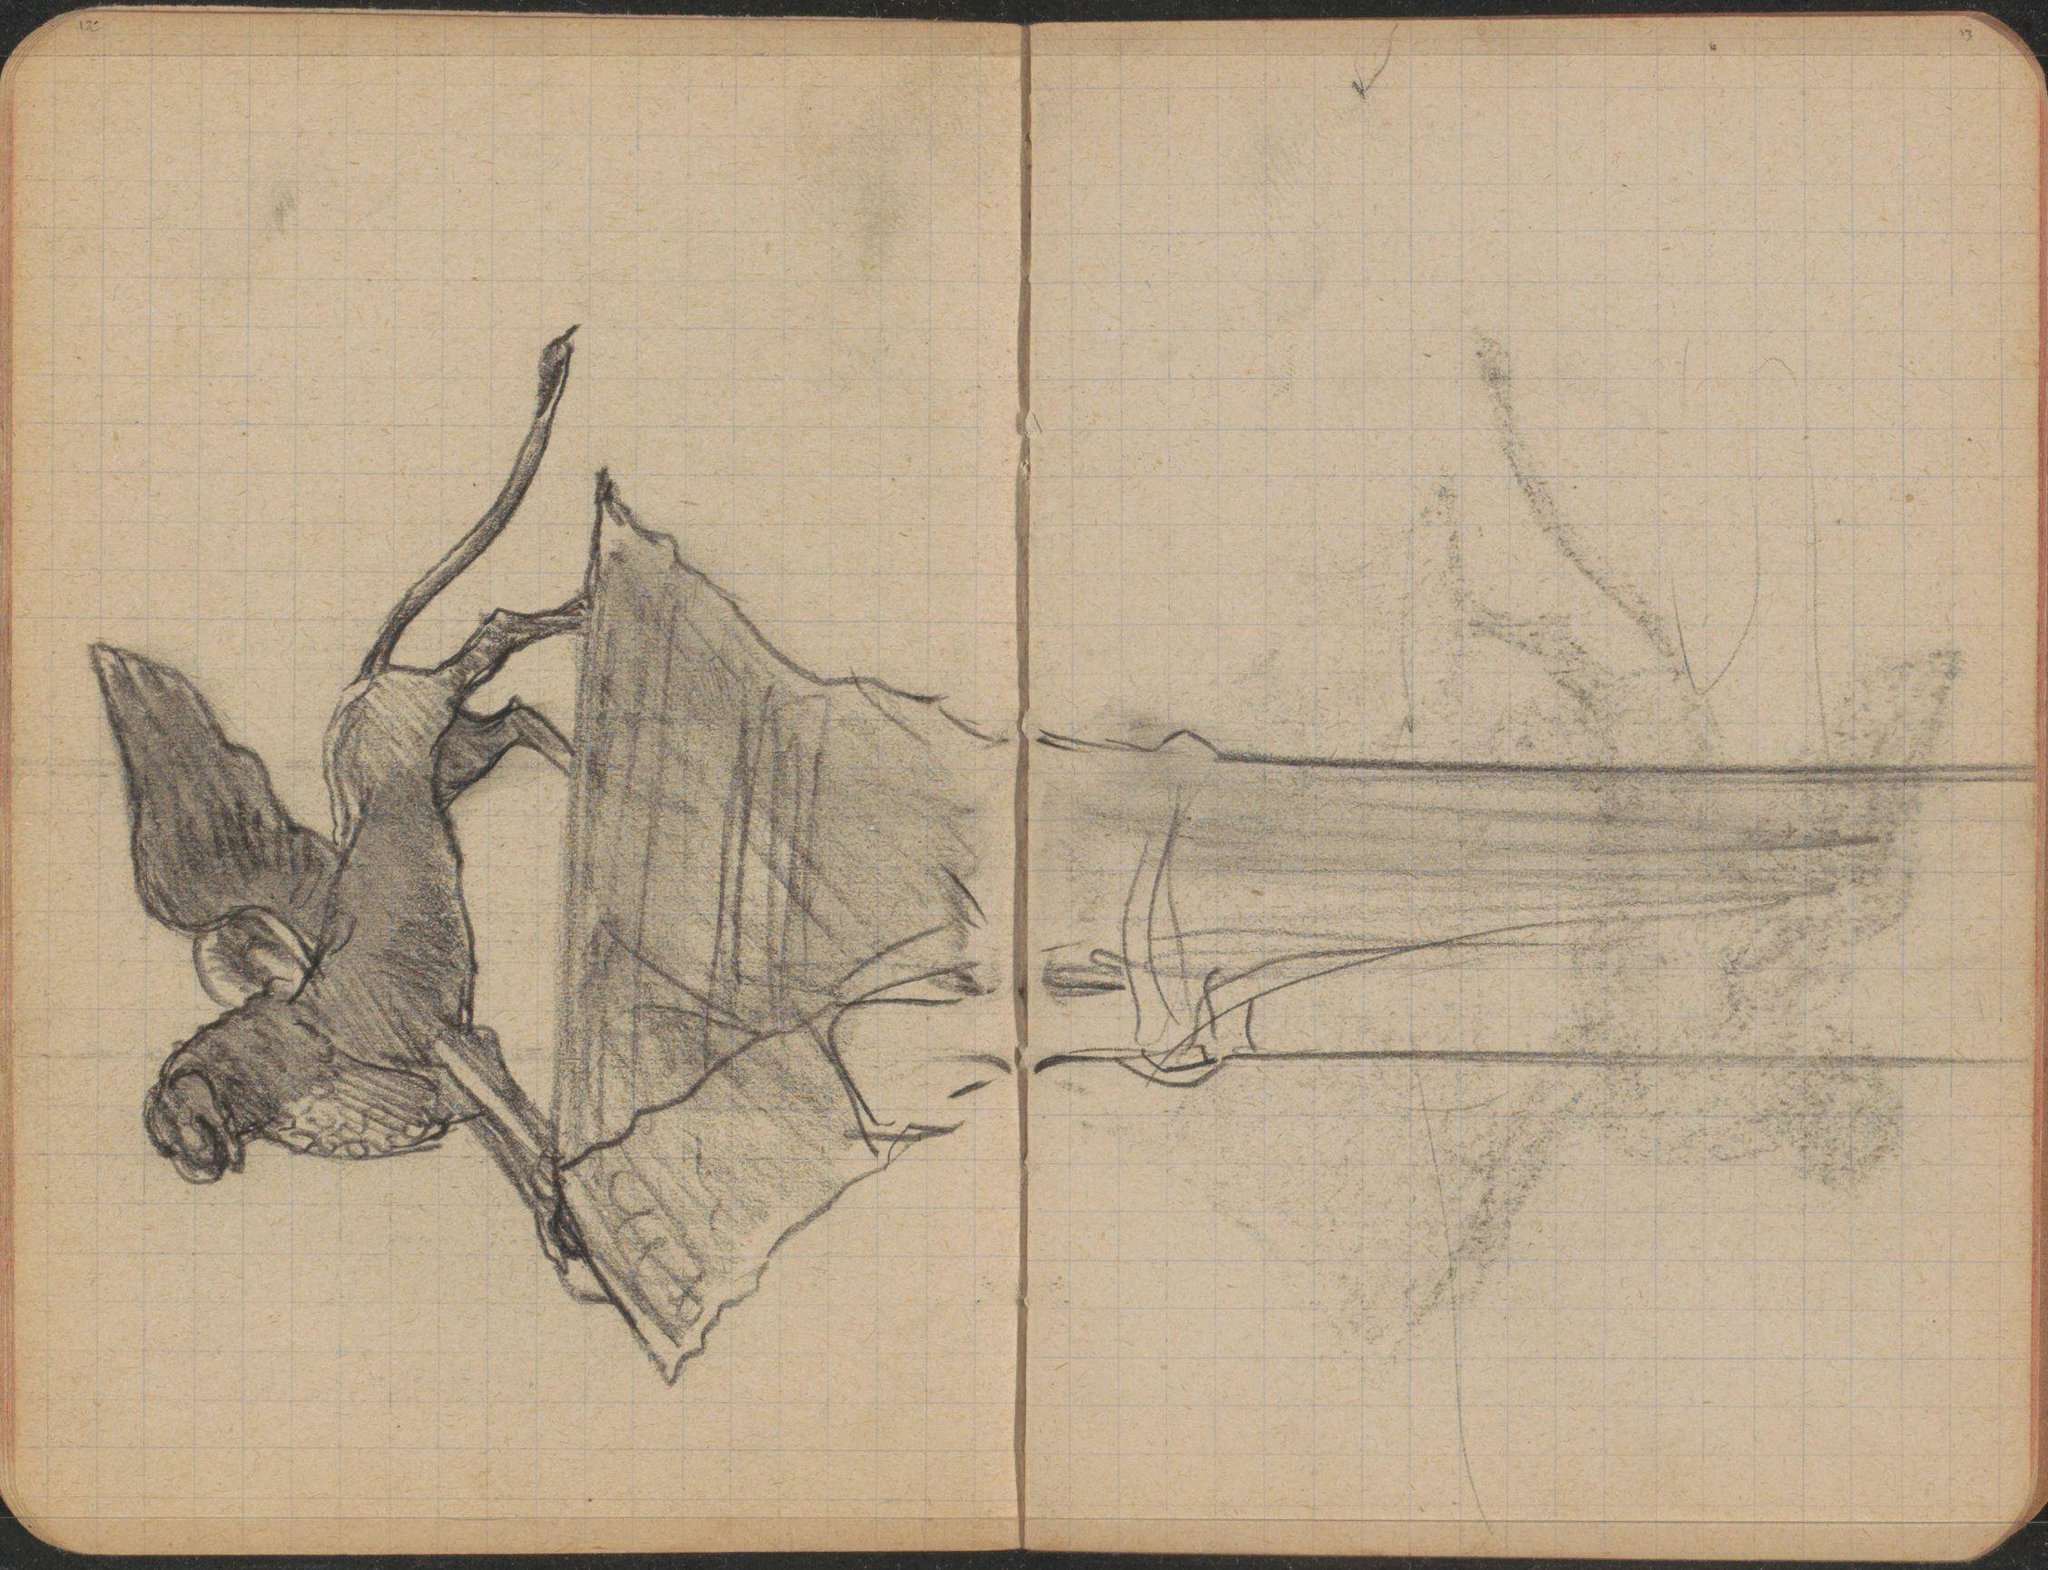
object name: sketchbook leaf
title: Zuil met het beeld van een gevleugelde leeuw bij het San Marco Plein in Venetië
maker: marius bauer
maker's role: draughtsman, print maker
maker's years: 1867-1932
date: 1895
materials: chalk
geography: venice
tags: column, pillar ~ architecture, sculpture, beasts of prey, predatory animals: lion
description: Het beeldhouwwerk van de 'Leeuw van Venetië' staat symbool voor de stad en de patroonheilige Sint Marcus.